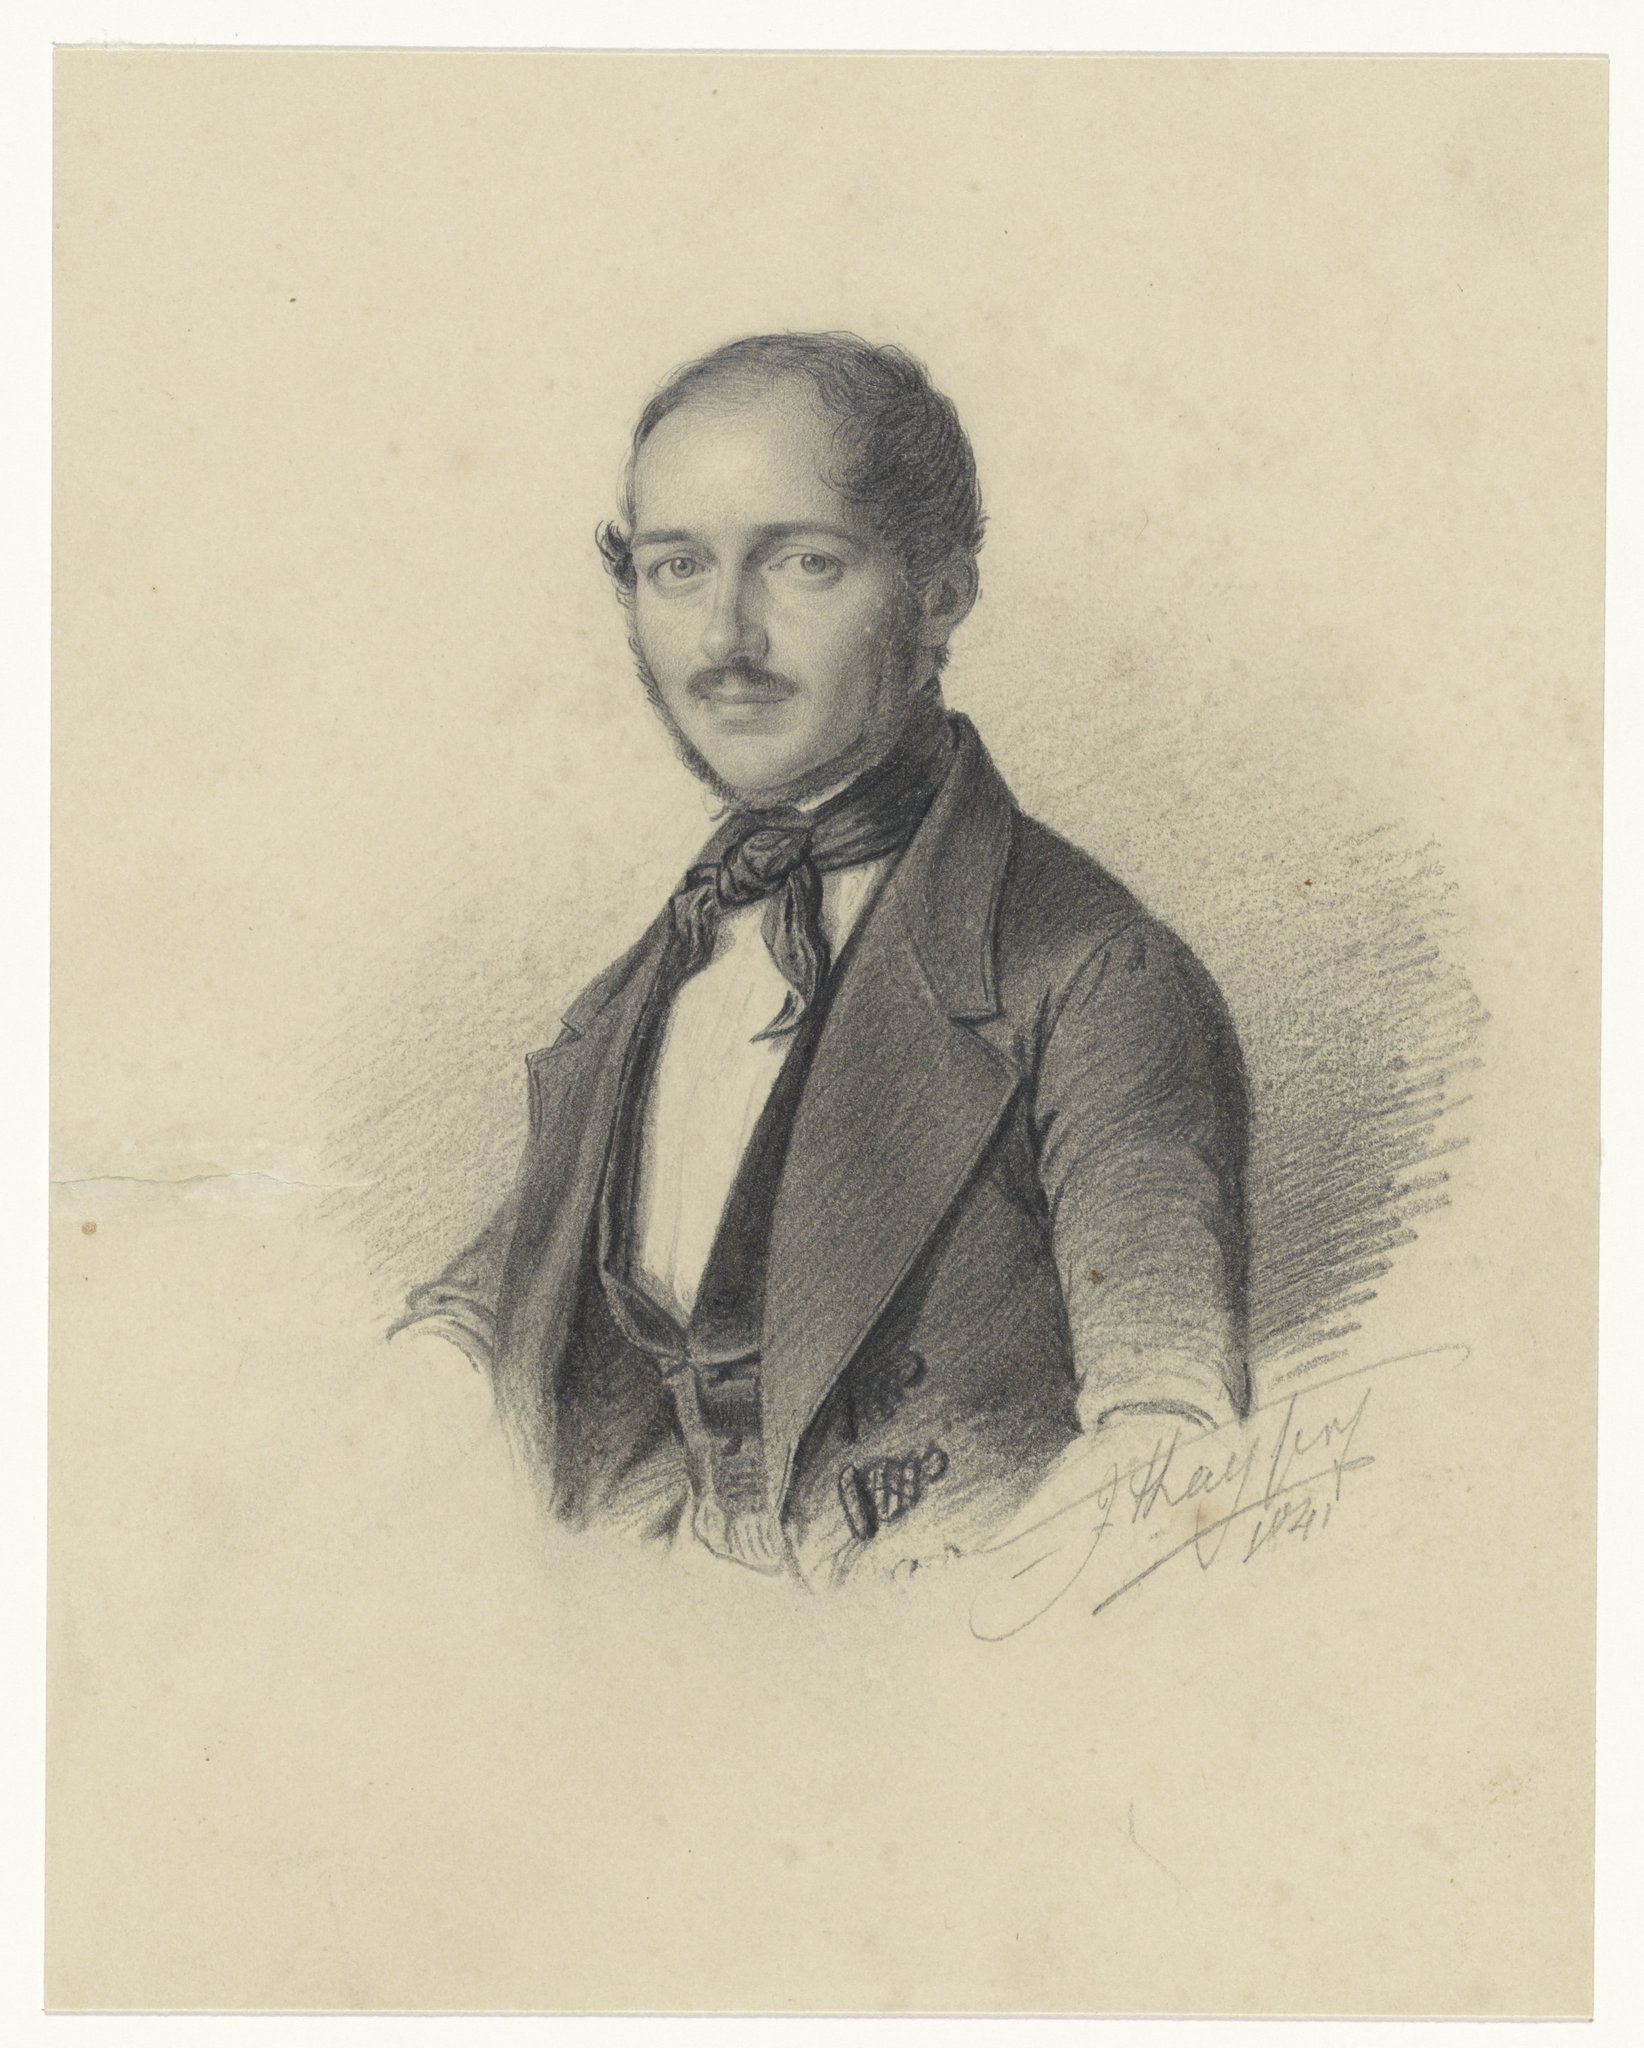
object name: drawing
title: Zelfportret van Joseph Kayser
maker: joseph kayser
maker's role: draughtsman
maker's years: 1803-1900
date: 1841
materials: paper, pencil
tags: belgium, draughtsman, joseph kayser, historical persons, portrait, self-portrait of artist, portrait, self-portrait of draughtsman